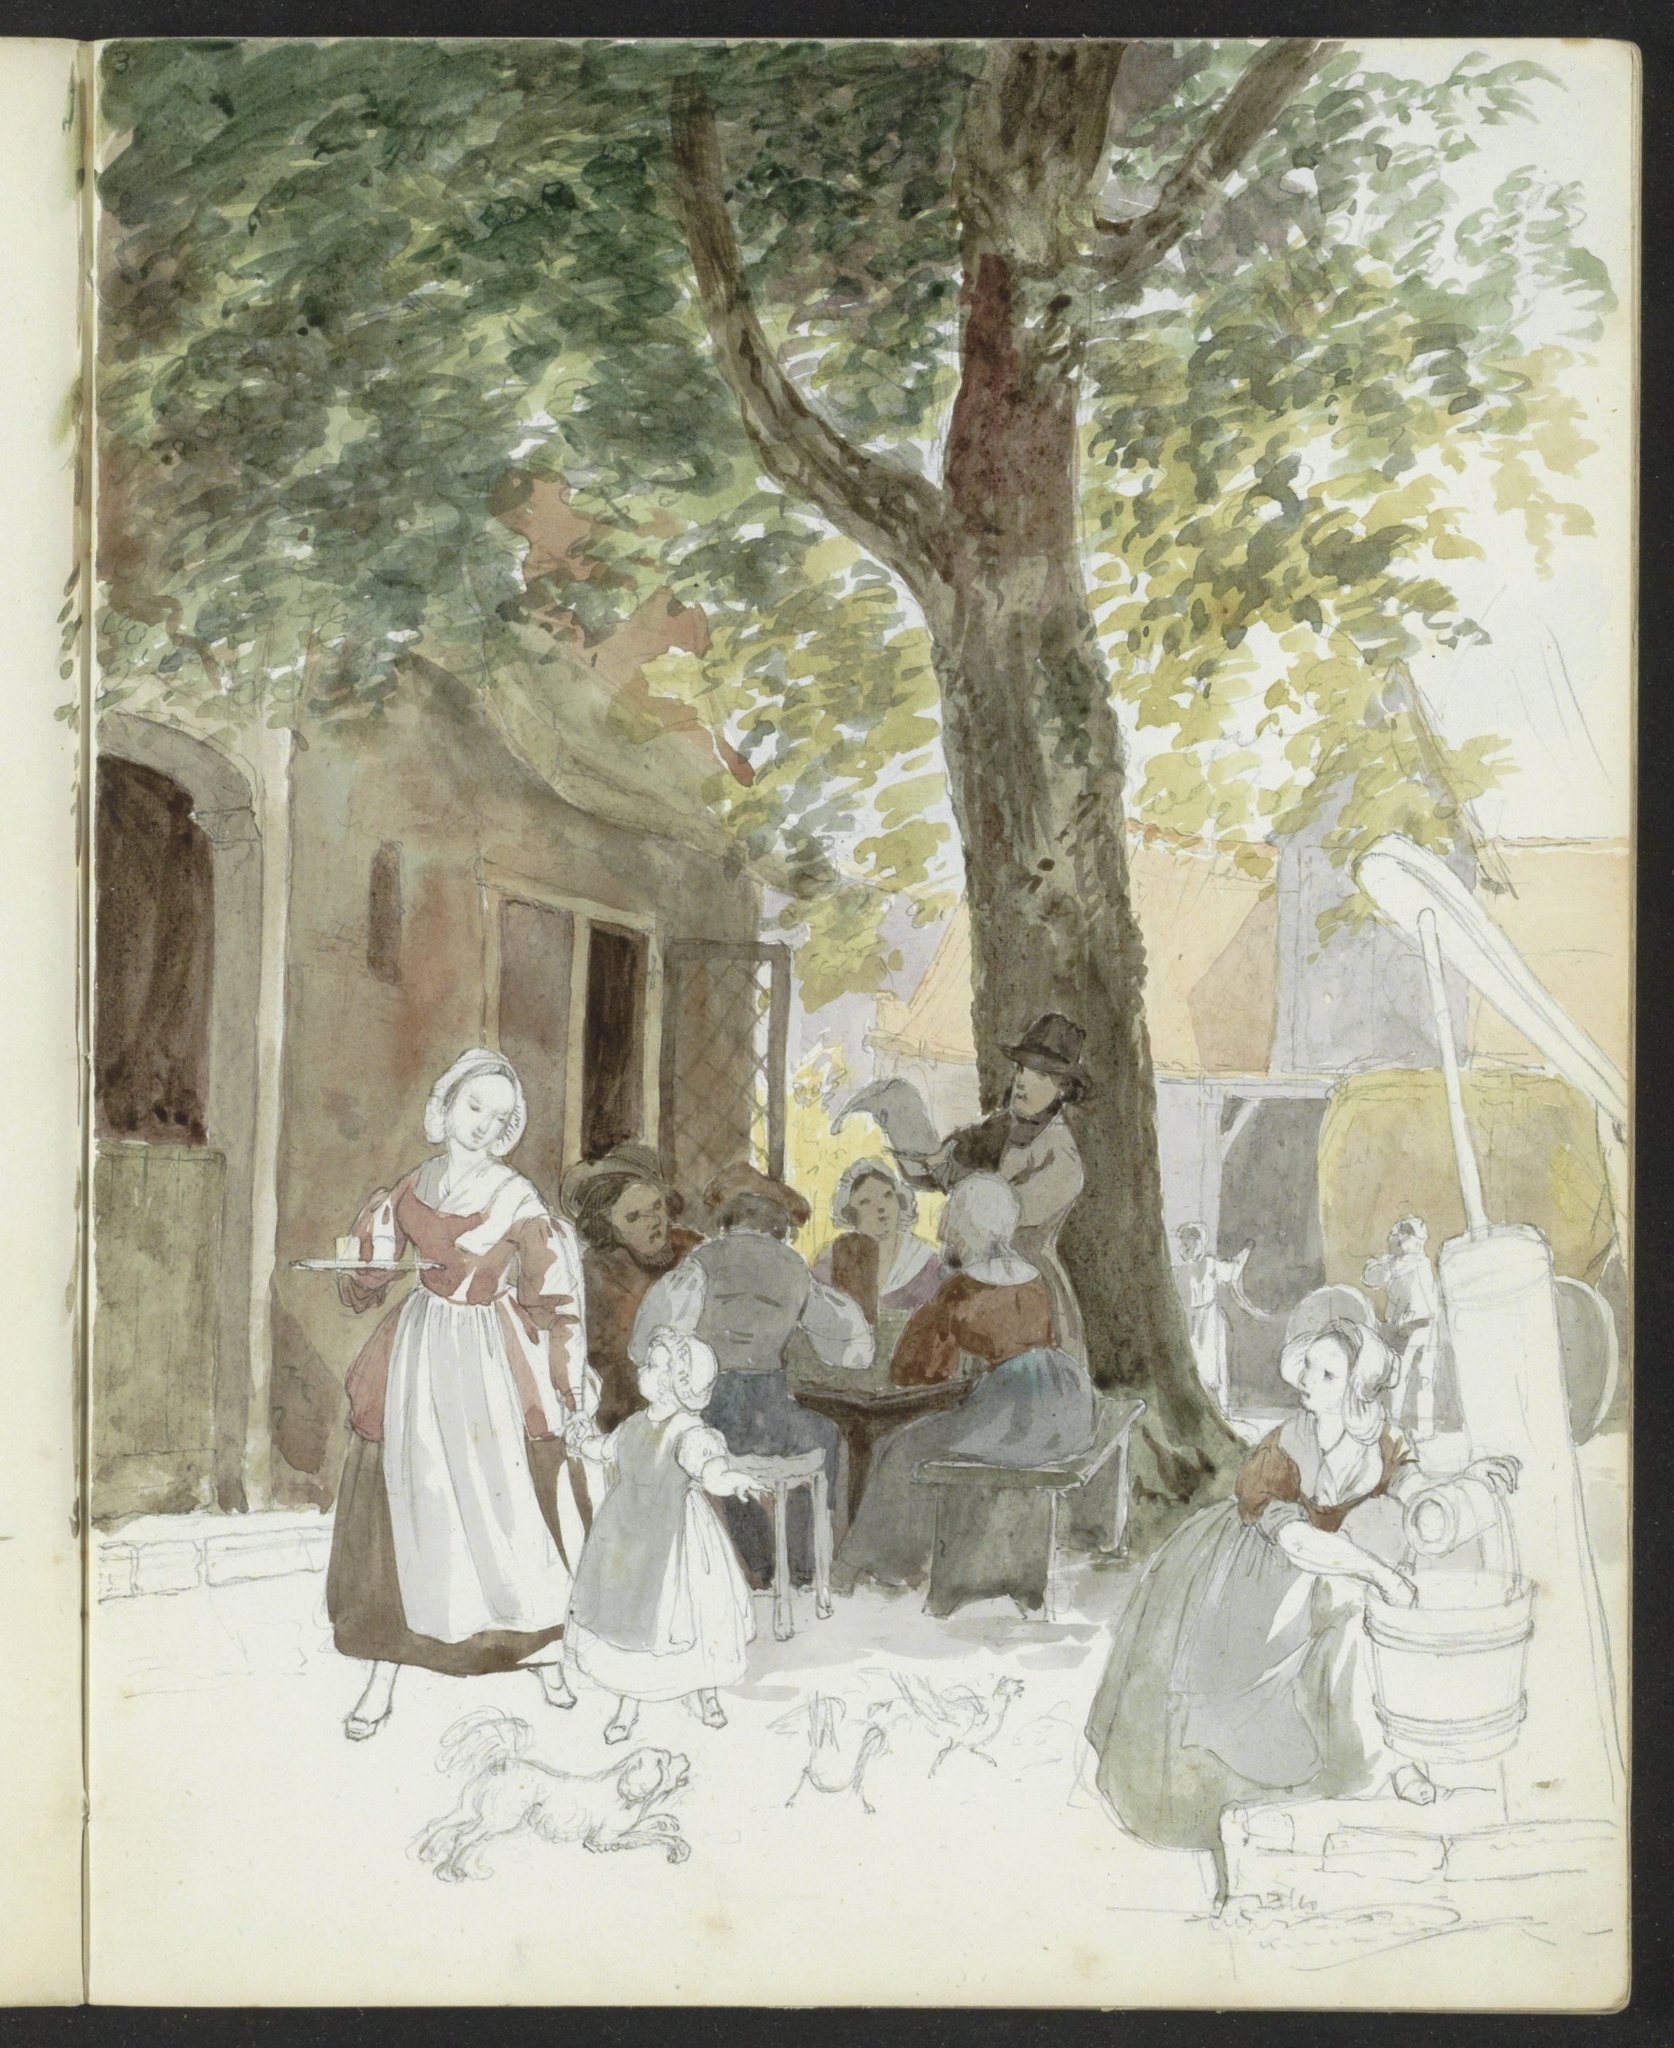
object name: sketchbook leaf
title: Dorpsstraat met een waterput en figuren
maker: hendrik abraham klinkhamer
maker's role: draughtsman, painter, print maker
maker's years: 1810-1872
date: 1820-1872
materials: paper, pencil, watercolor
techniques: brush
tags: well, pavement, terrace in front of inn or restaurant, hay-wagon, village street (+ city(-scape) with figures, staffage)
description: Op de voorgrond loopt een moeder met kind en haalt een vrouw water uit een put. Bij een boom zit een groep figuren rond een tafel. Op de achtergrond een hooiwagen bij een schuur. Recto van een foutief genummerd blad tussen blad 3 en 4 uit een schetsboek met 21 bladen.